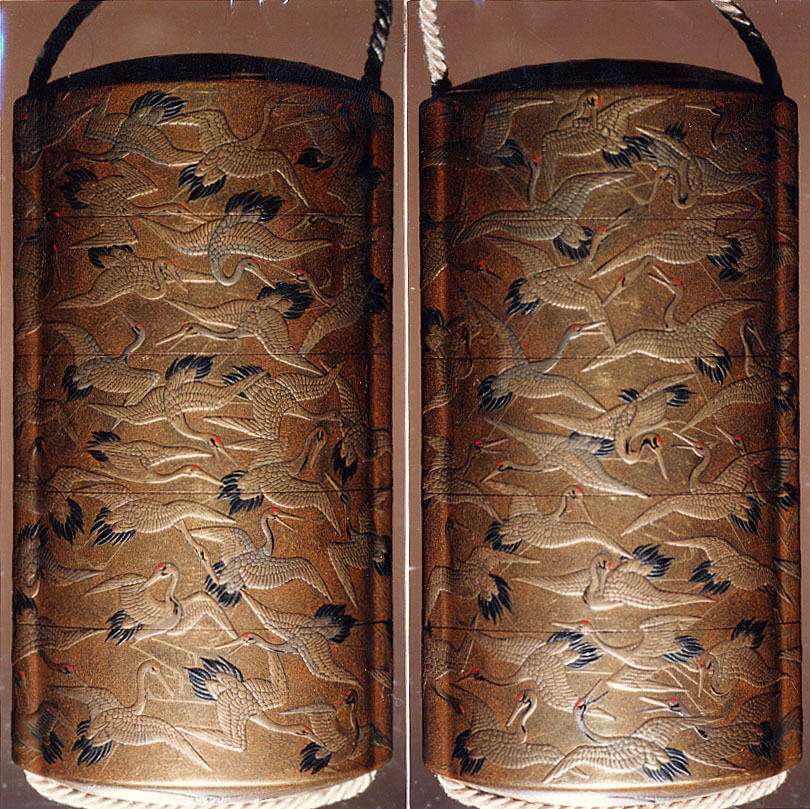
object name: inrō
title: Case (Inrō) with Design of Cranes in Flight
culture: japanese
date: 1801-1900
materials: gold, lacquer, silver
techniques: fundame, hiramakie, maki-e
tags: cranes